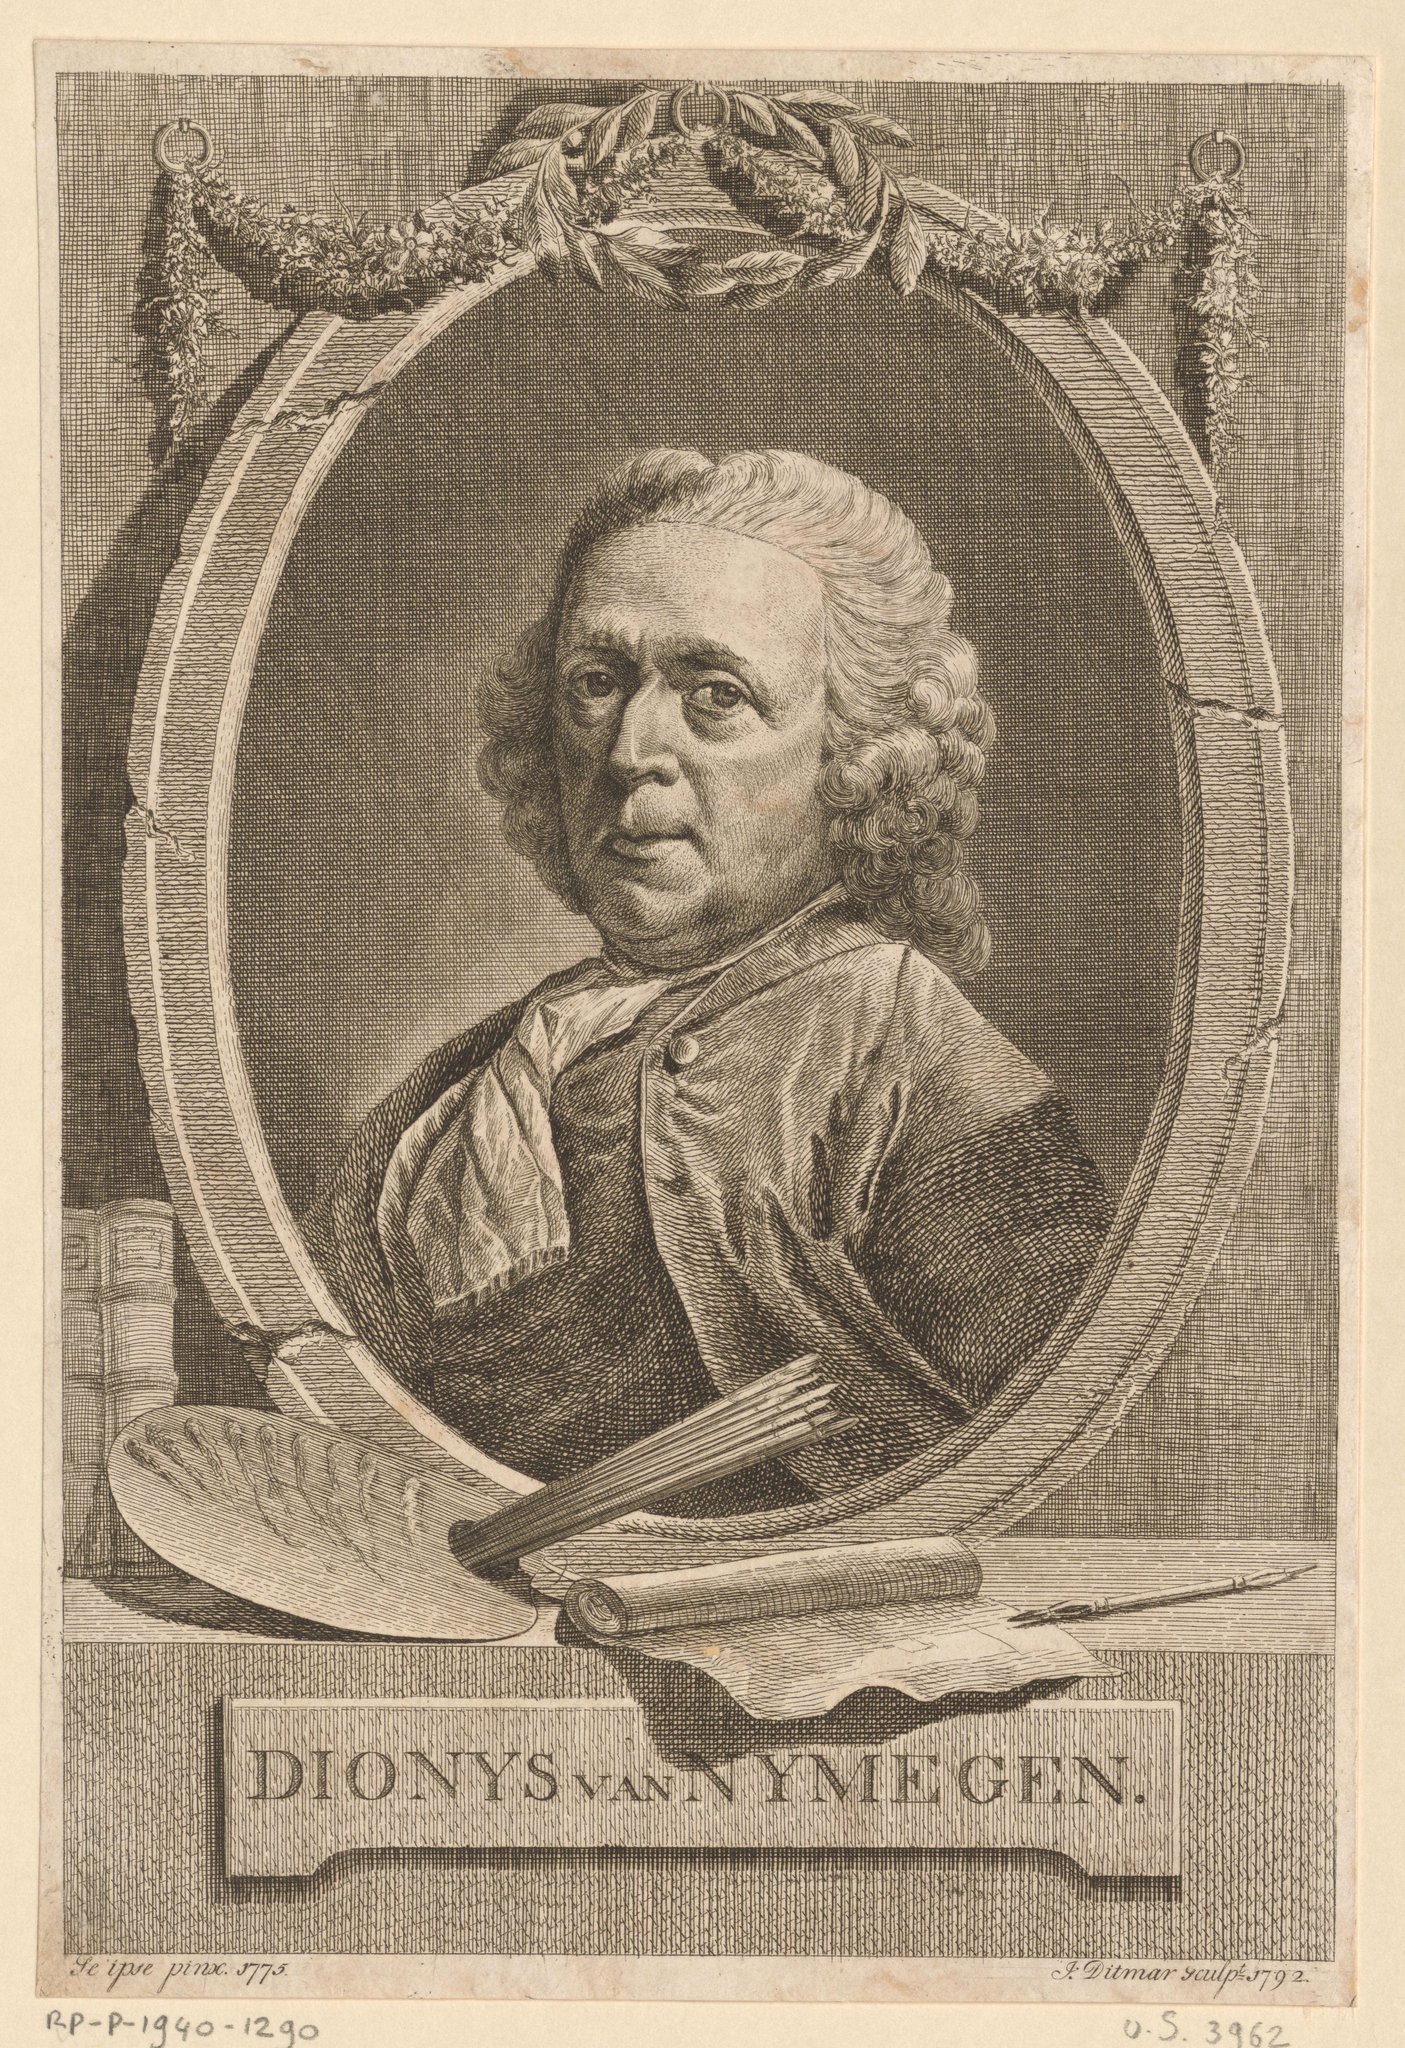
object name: print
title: Portret van Dionys van Nijmegen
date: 1792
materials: paper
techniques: engraving, etching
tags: rotterdam, painter, draughtsman, dionys van nijmegen, historical persons, tools, implements of painter, portrait, self-portrait of artist